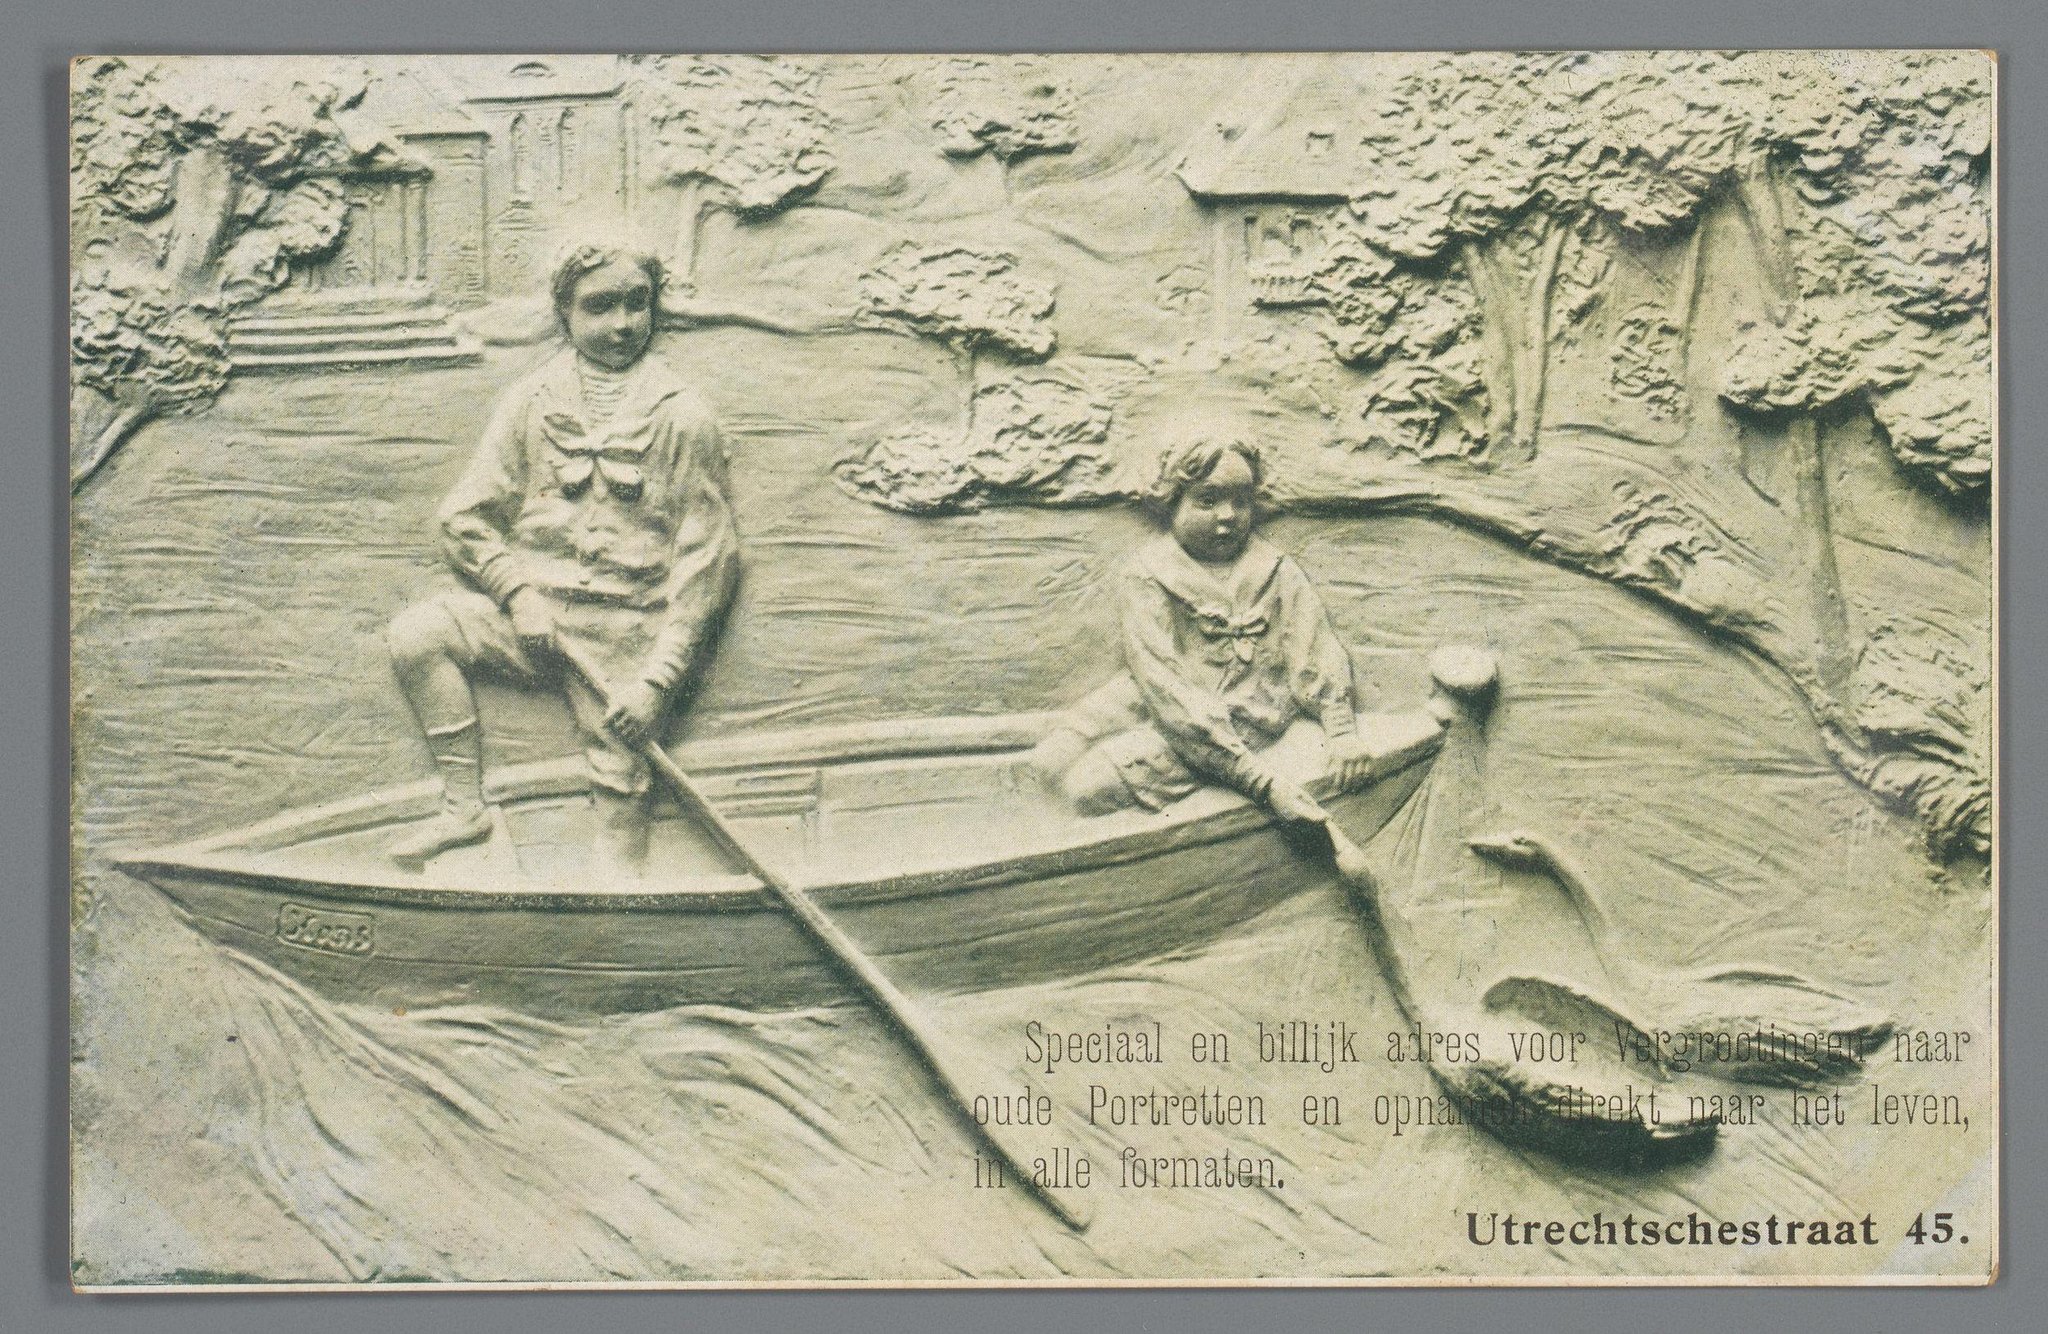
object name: photomechanical print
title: Fotoreproductie van reliëf van kinderen in een roeiboot als reclame voor een fotograaf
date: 1892-1905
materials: cardboard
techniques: writing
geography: amsterdam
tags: rowing-boat, canoe, etc.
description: Hoewel de kaart is gebruikt om de ontvanger een goed 1967 te wensen, is de kaart zelf ongveer zestig jaar ouder.